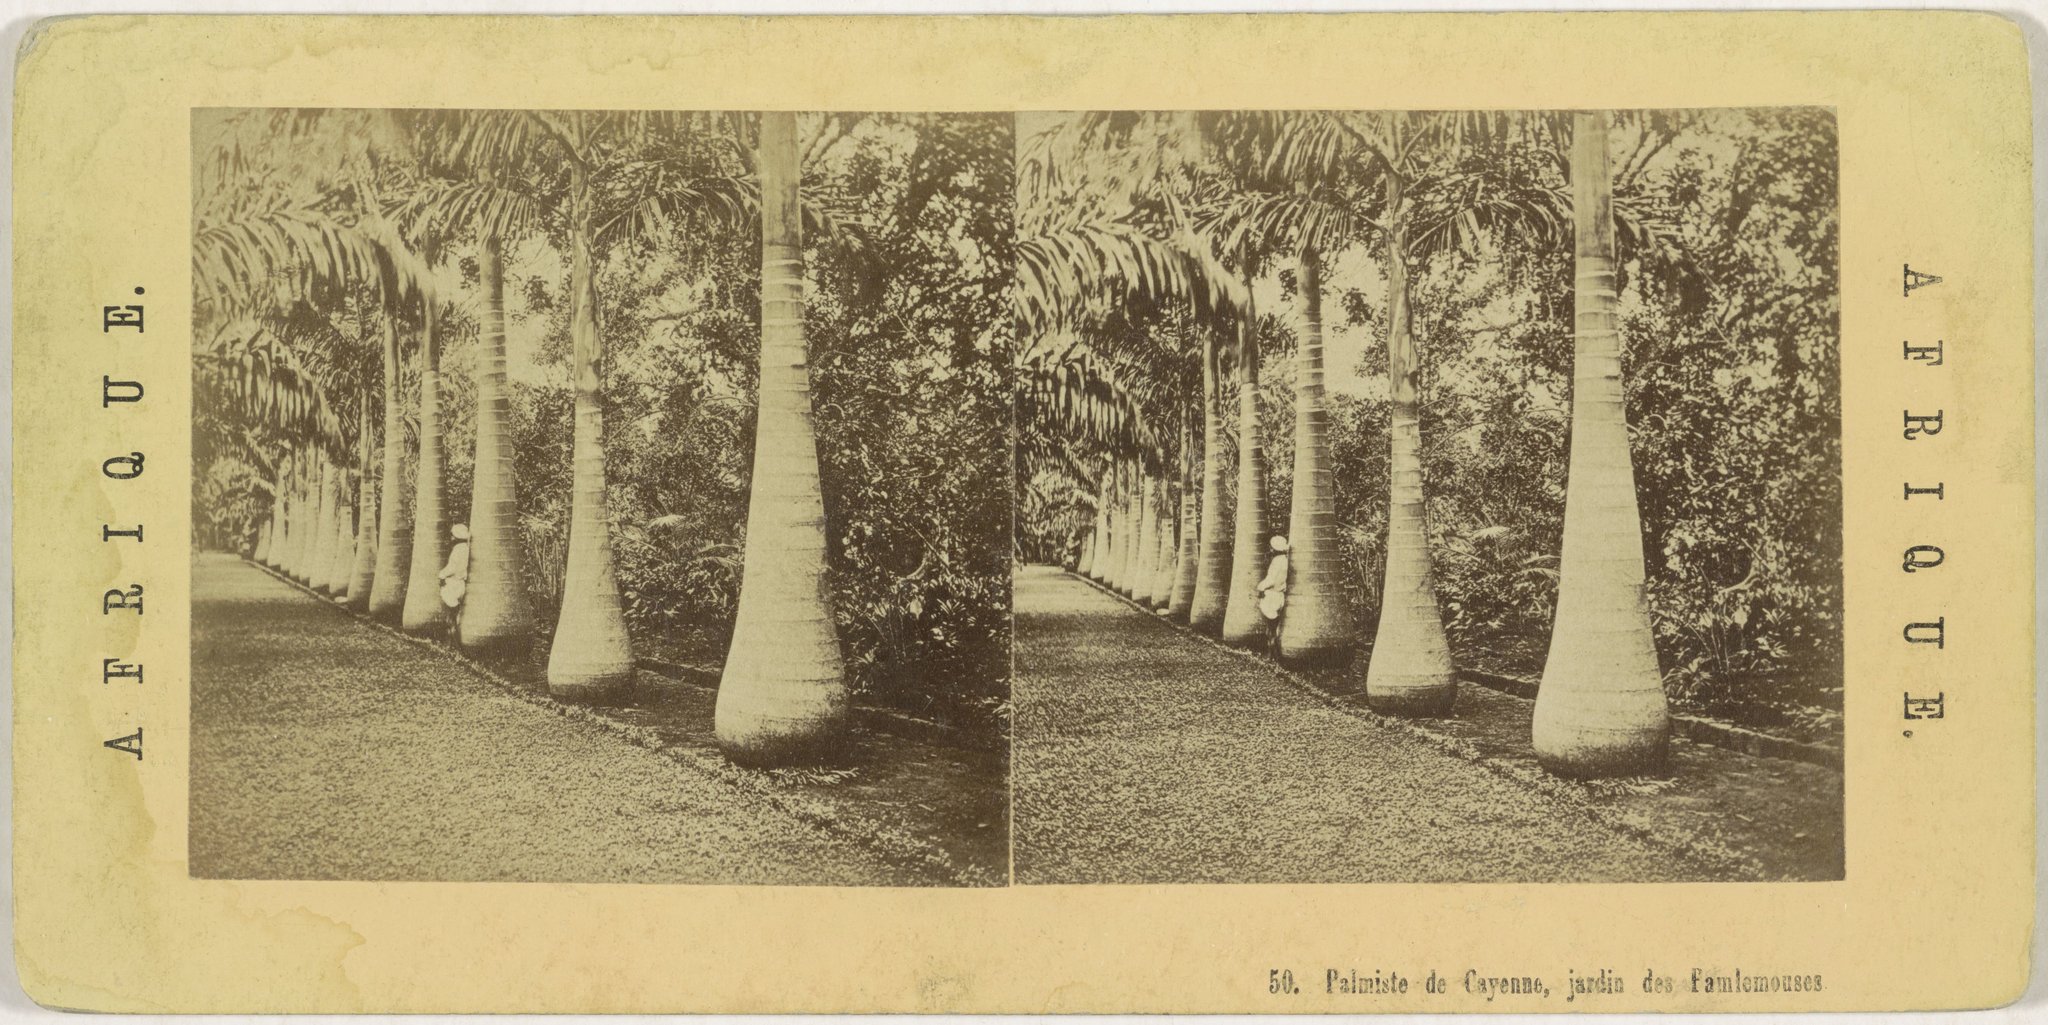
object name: stereograph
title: Palmen in de Jardin de Pamplemousse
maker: Anonymous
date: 1868-1890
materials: cardboard, paper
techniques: albumen print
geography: mauritius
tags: trees: palm-tree, botanic garden, 'hortus botanicus'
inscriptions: number: ‘50.’